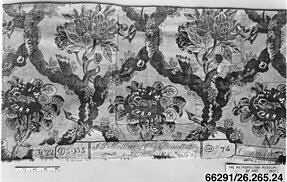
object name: floral print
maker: j.p. meillier et cie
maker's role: manufactory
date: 1785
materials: linen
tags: flowers